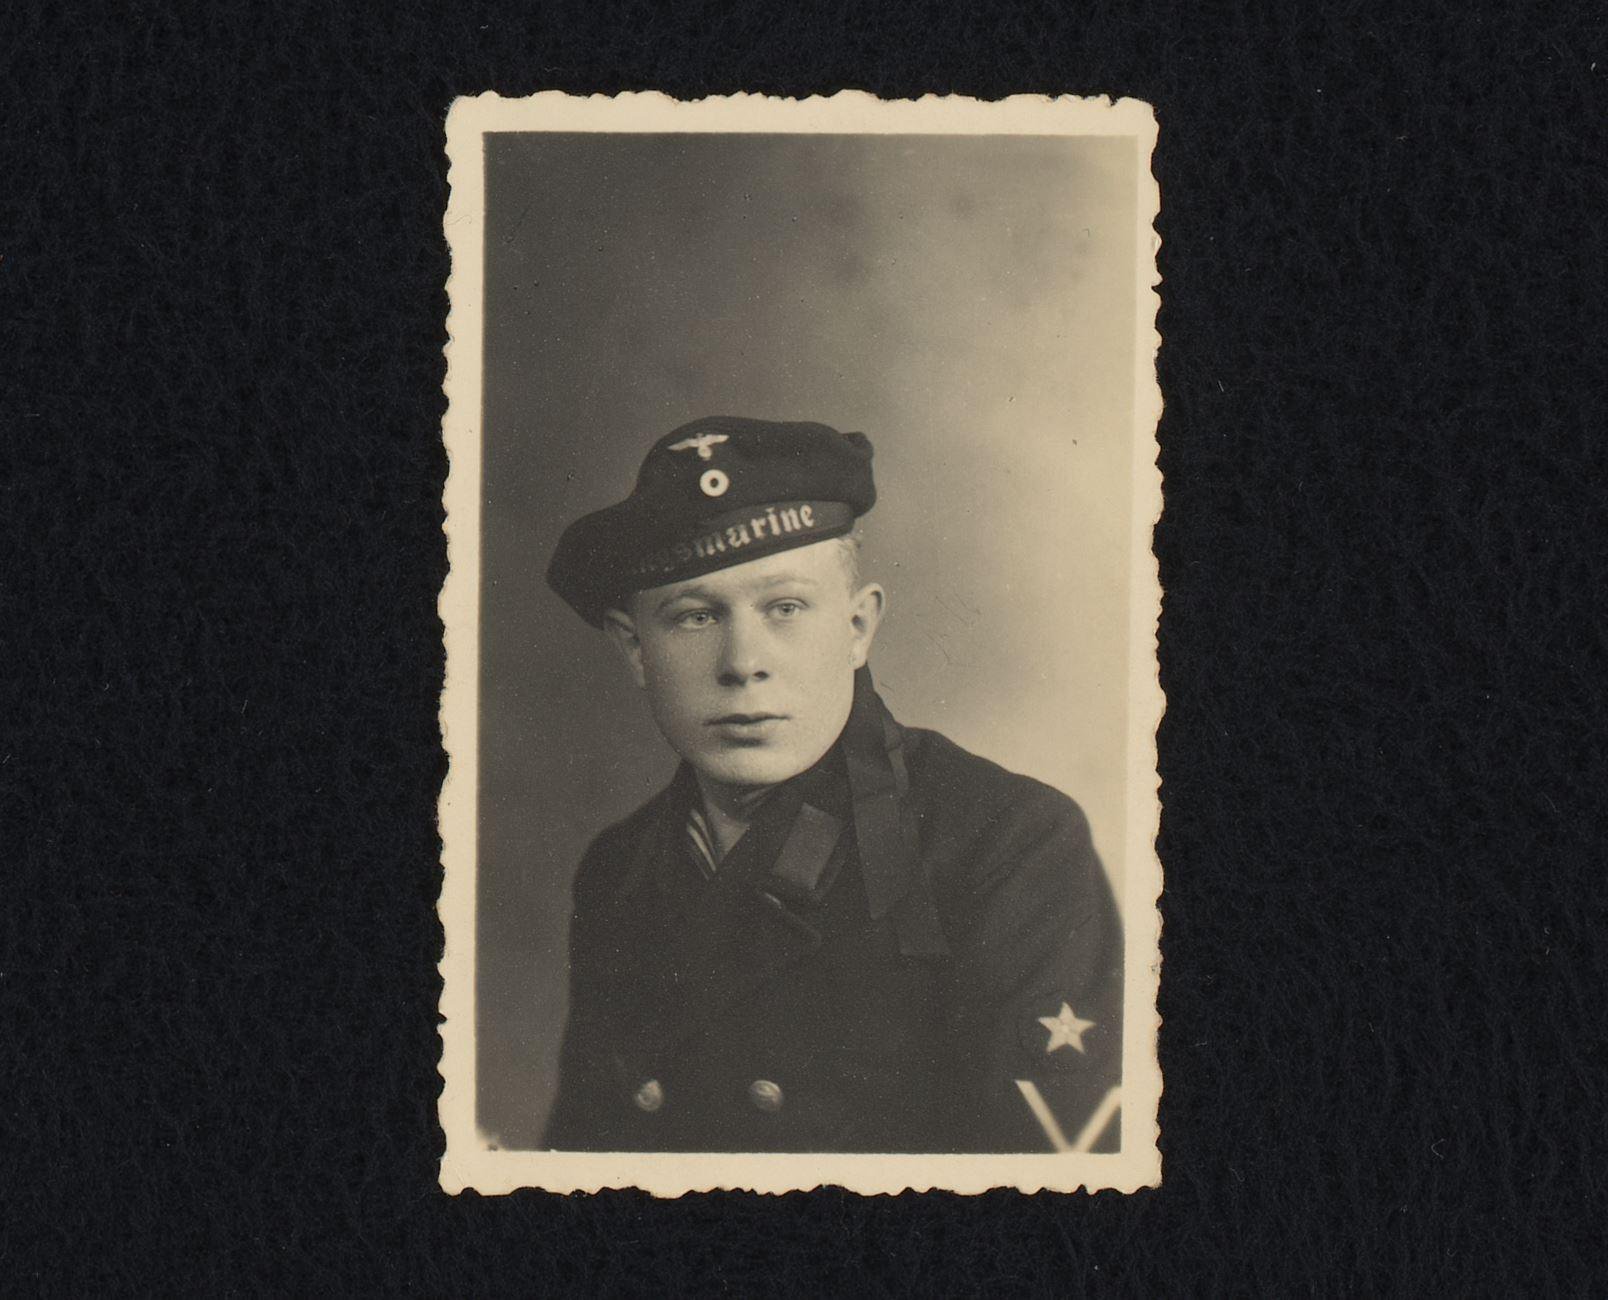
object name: photograph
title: Portret van een Duitse matroos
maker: Anonymous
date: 1940-1943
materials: photographic support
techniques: gelatin silver print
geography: france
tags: the company, the unit, the troop ~ military service, sailor, netherlands, france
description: Portret van een matroos van de Kriegsmarine. Onderdeel van de groep losse foto's behorend bij het fotoalbum over de Kriegsmarine 1940-1943.